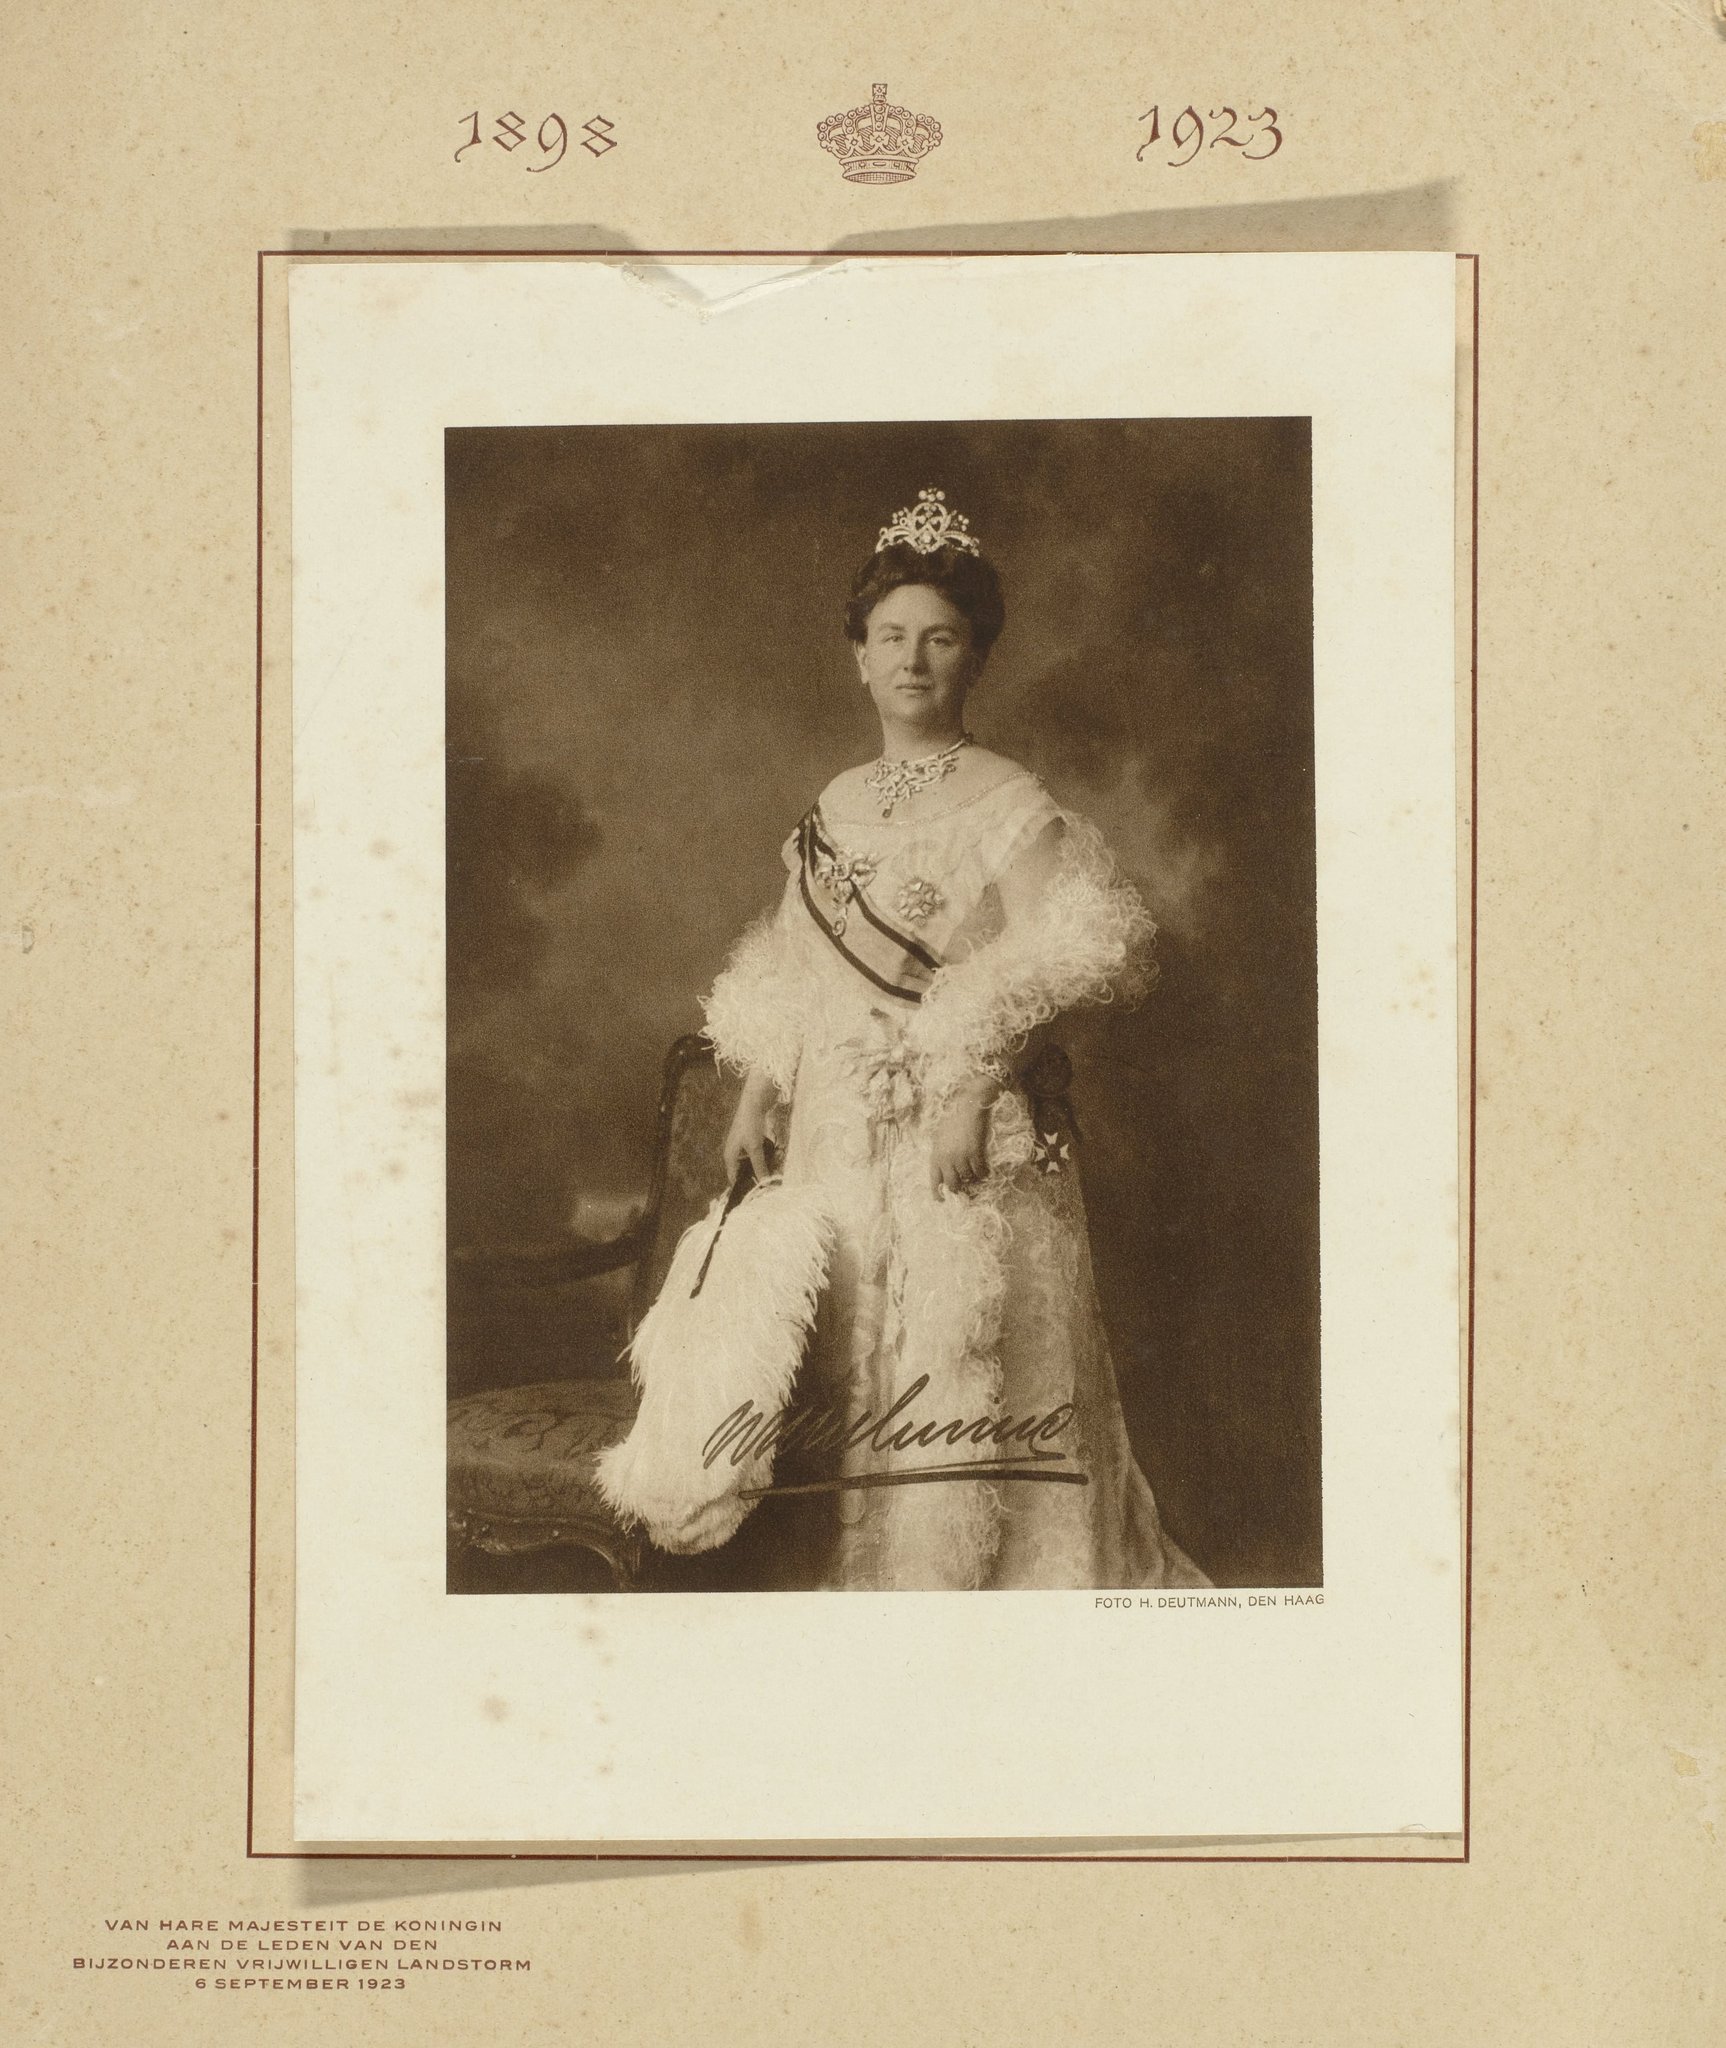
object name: photograph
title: Wilhelmina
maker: herman deutmann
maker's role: fotograaf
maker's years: 1870-1926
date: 1923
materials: cardboard, paper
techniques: photography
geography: netherlands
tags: the hague, wilhelmina of the netherlands, netherlands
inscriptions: date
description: Koningin Wilhelmina op ca. 40 jariger leeftijd. Bovenkant foto op karton vastgeplakt, bruingetint, met de handtekening van Wilhelmina. Gemaakt ter ere van haar 25 jarig regeringsjubileum, voor de leden van de Bijzondere Vrijwillige Landstorm.